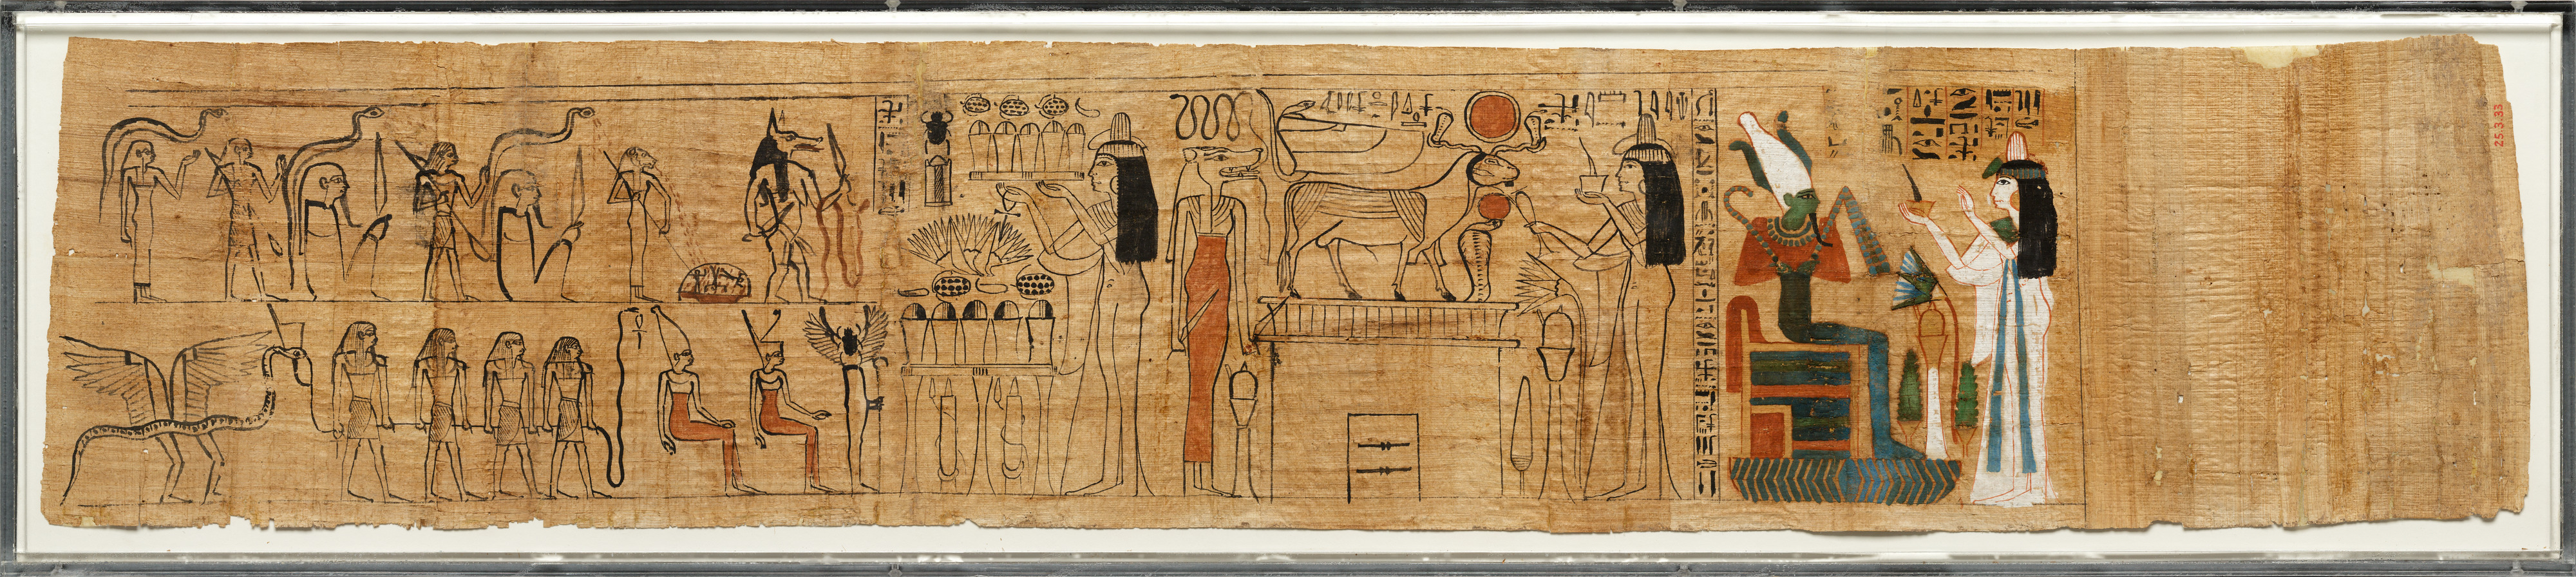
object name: papyrus, funerary, tiye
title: Amduat Papyrus Inscribed for Tiye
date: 975-945 BCE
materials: ink, papyrus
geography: egypt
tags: animals,women,hieroglyphs,snakes